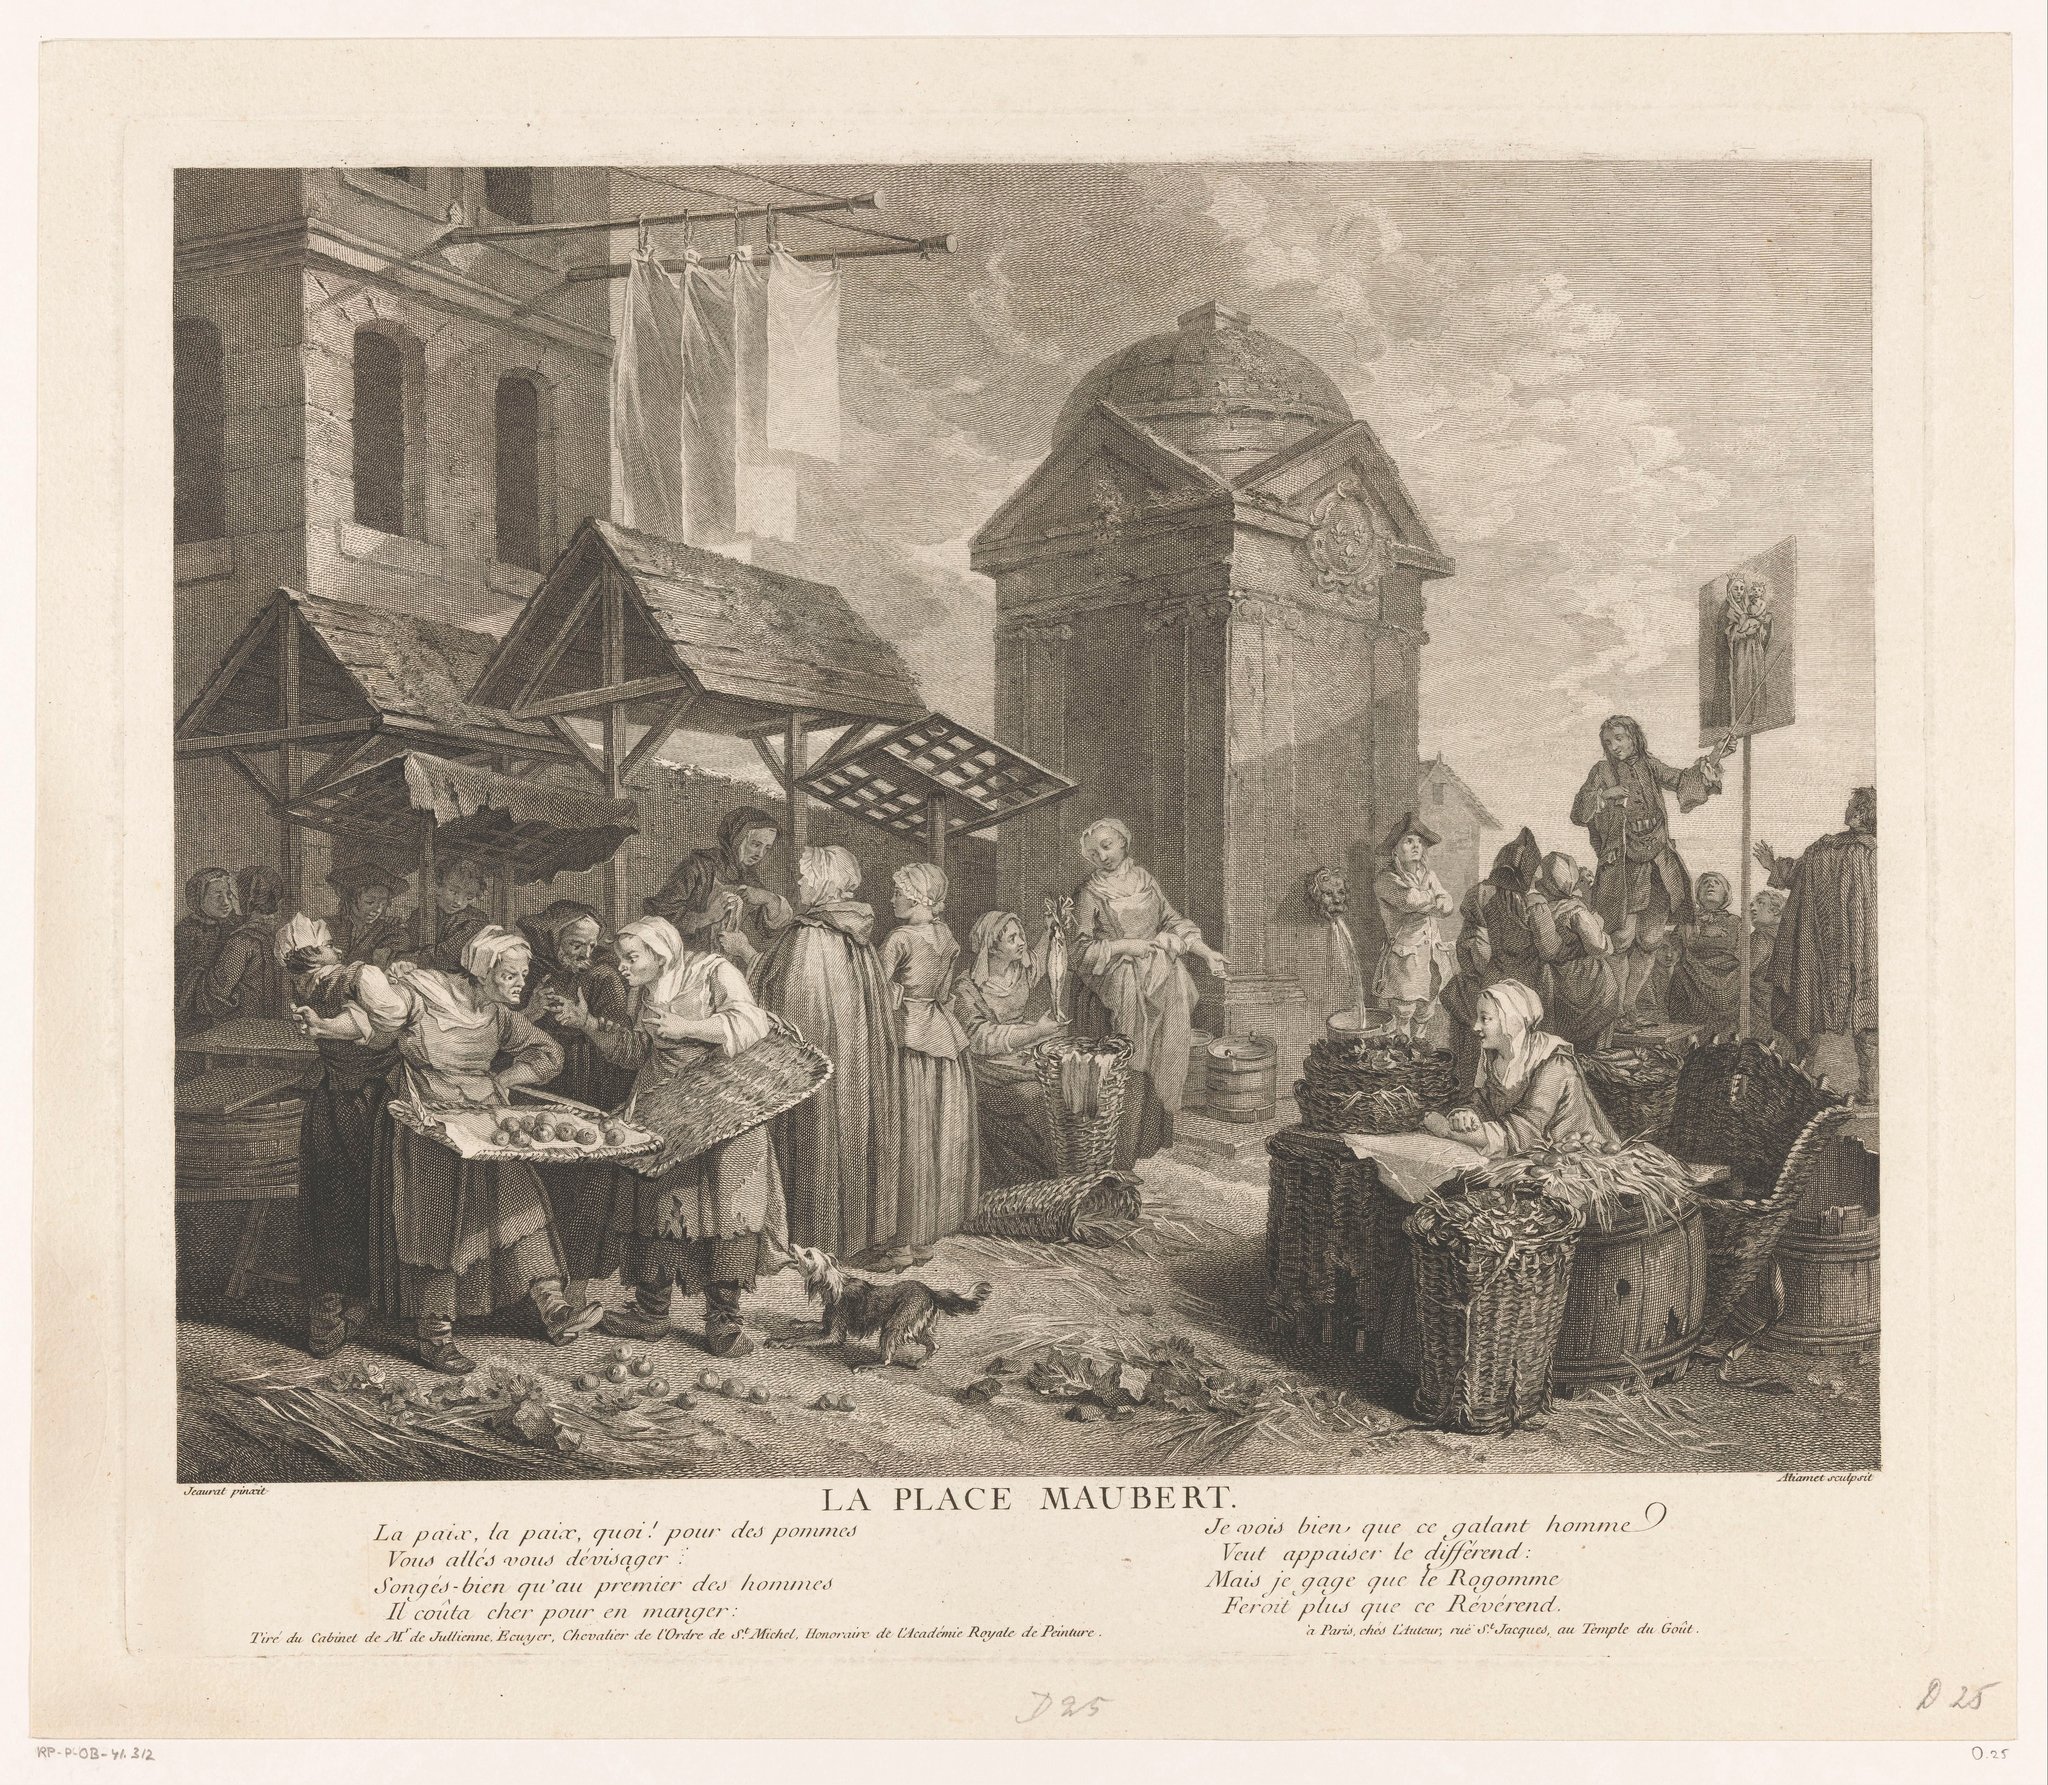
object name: print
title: La place Maubert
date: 1753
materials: paper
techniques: engraving, etching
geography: paris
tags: story teller; listening to story teller, market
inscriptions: collector's mark: Lugt 2228